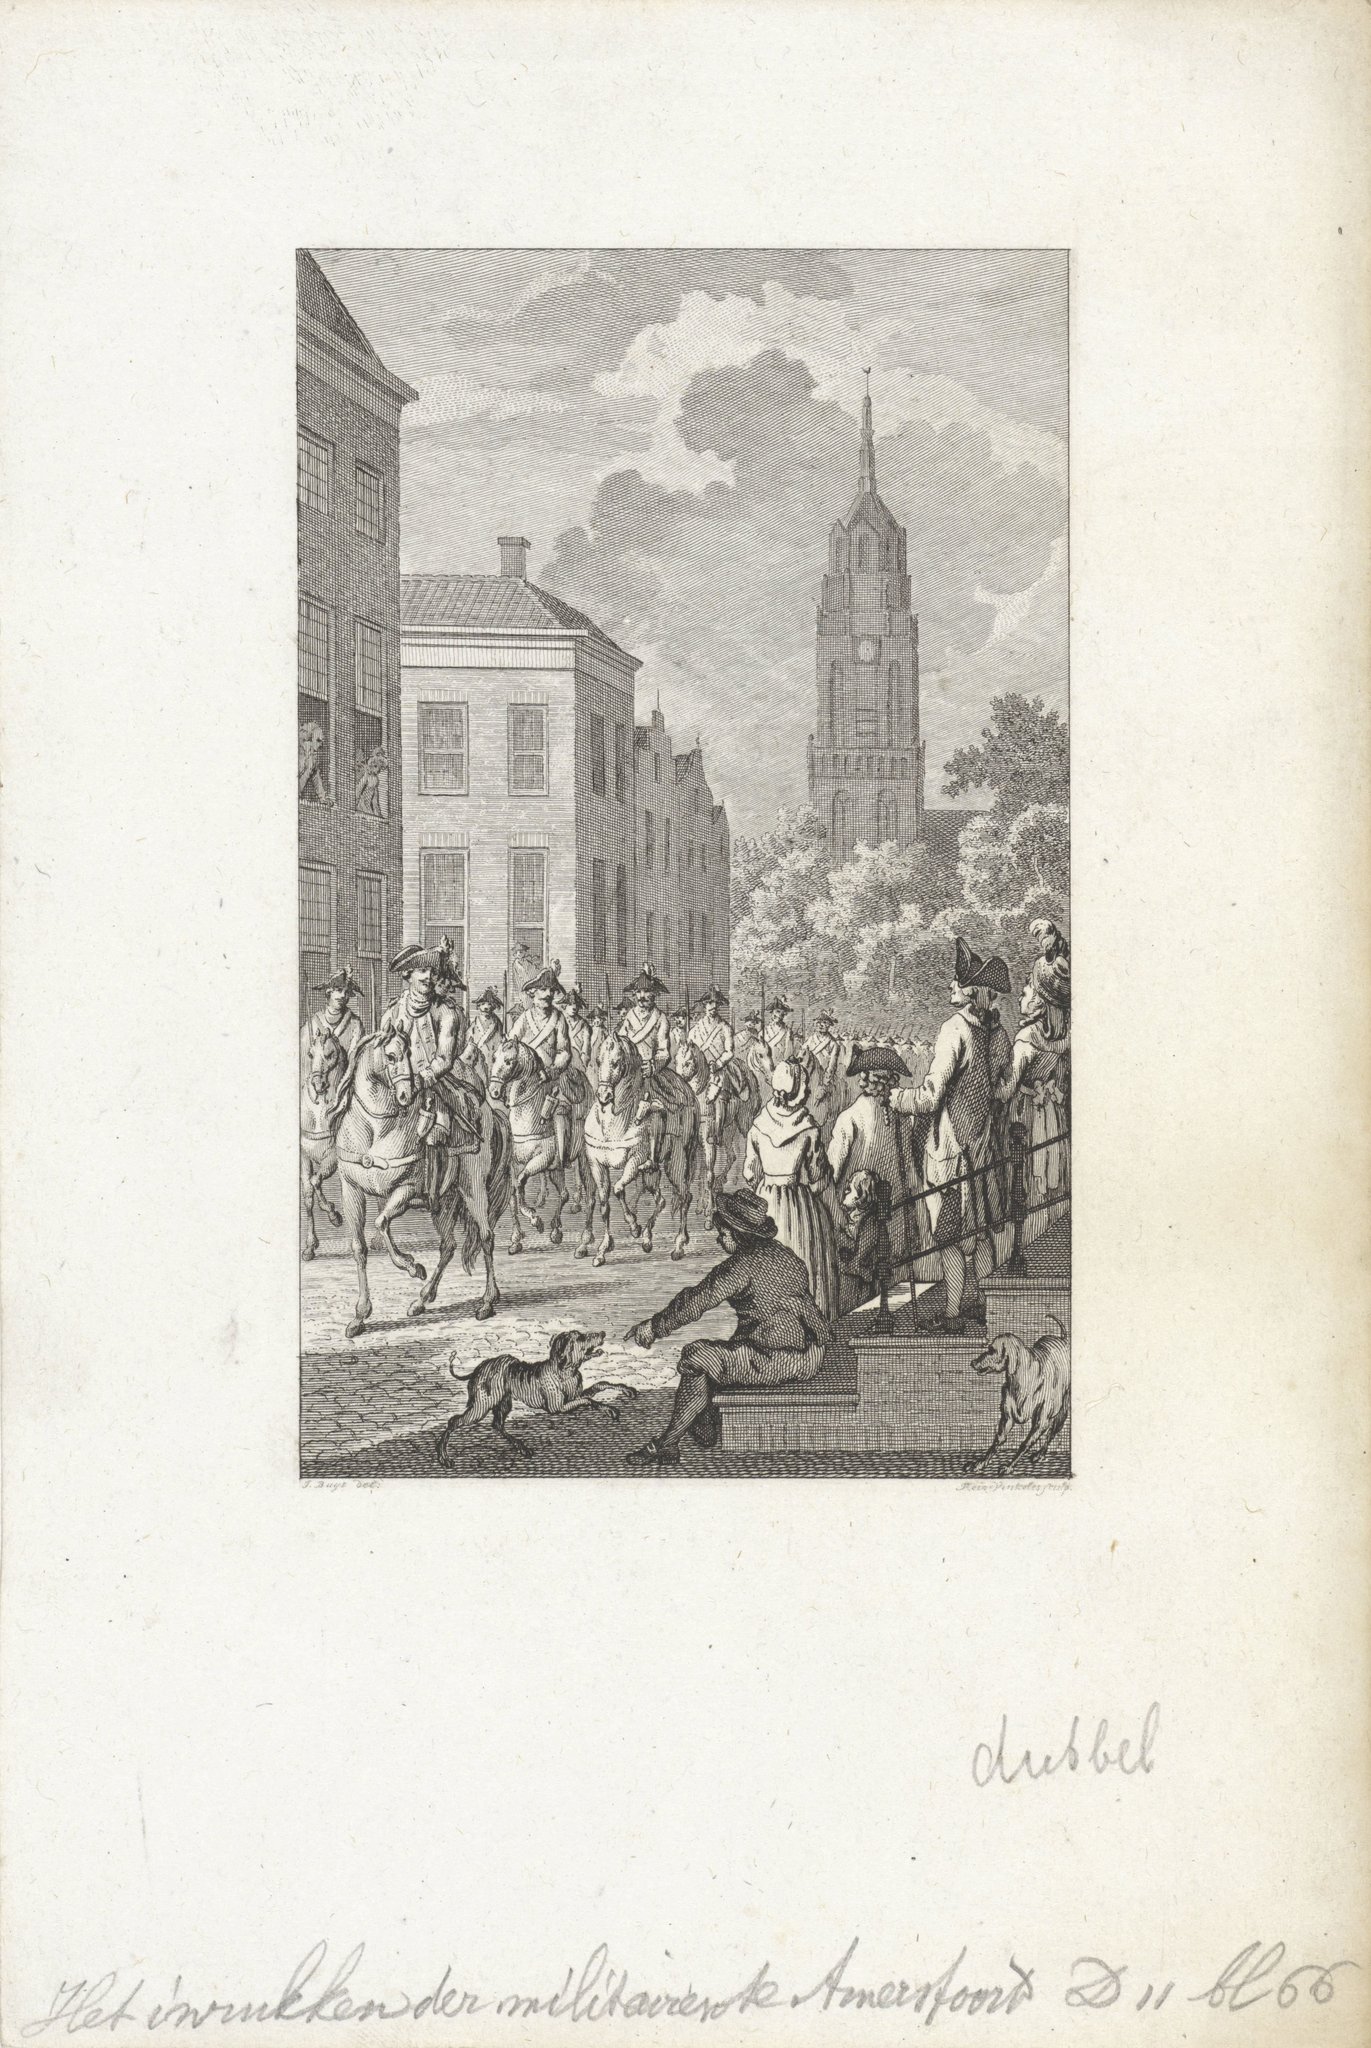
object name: print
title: Inrukken van militairen in Amersfoort, 1785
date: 1793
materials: paper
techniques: etching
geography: amsterdam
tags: patriots (1780-1795)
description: Gebruikt als illustratie in: P.A. Loosjes. Vaderlandsche historie, vervattende de geschiedenissen, der Vereenigde Nederlanden (...). Ten onmiddelyken vervolge van Wagenaar's Vaderlandsche historie. Amsterdam: Johannes Allart, dl. 11.